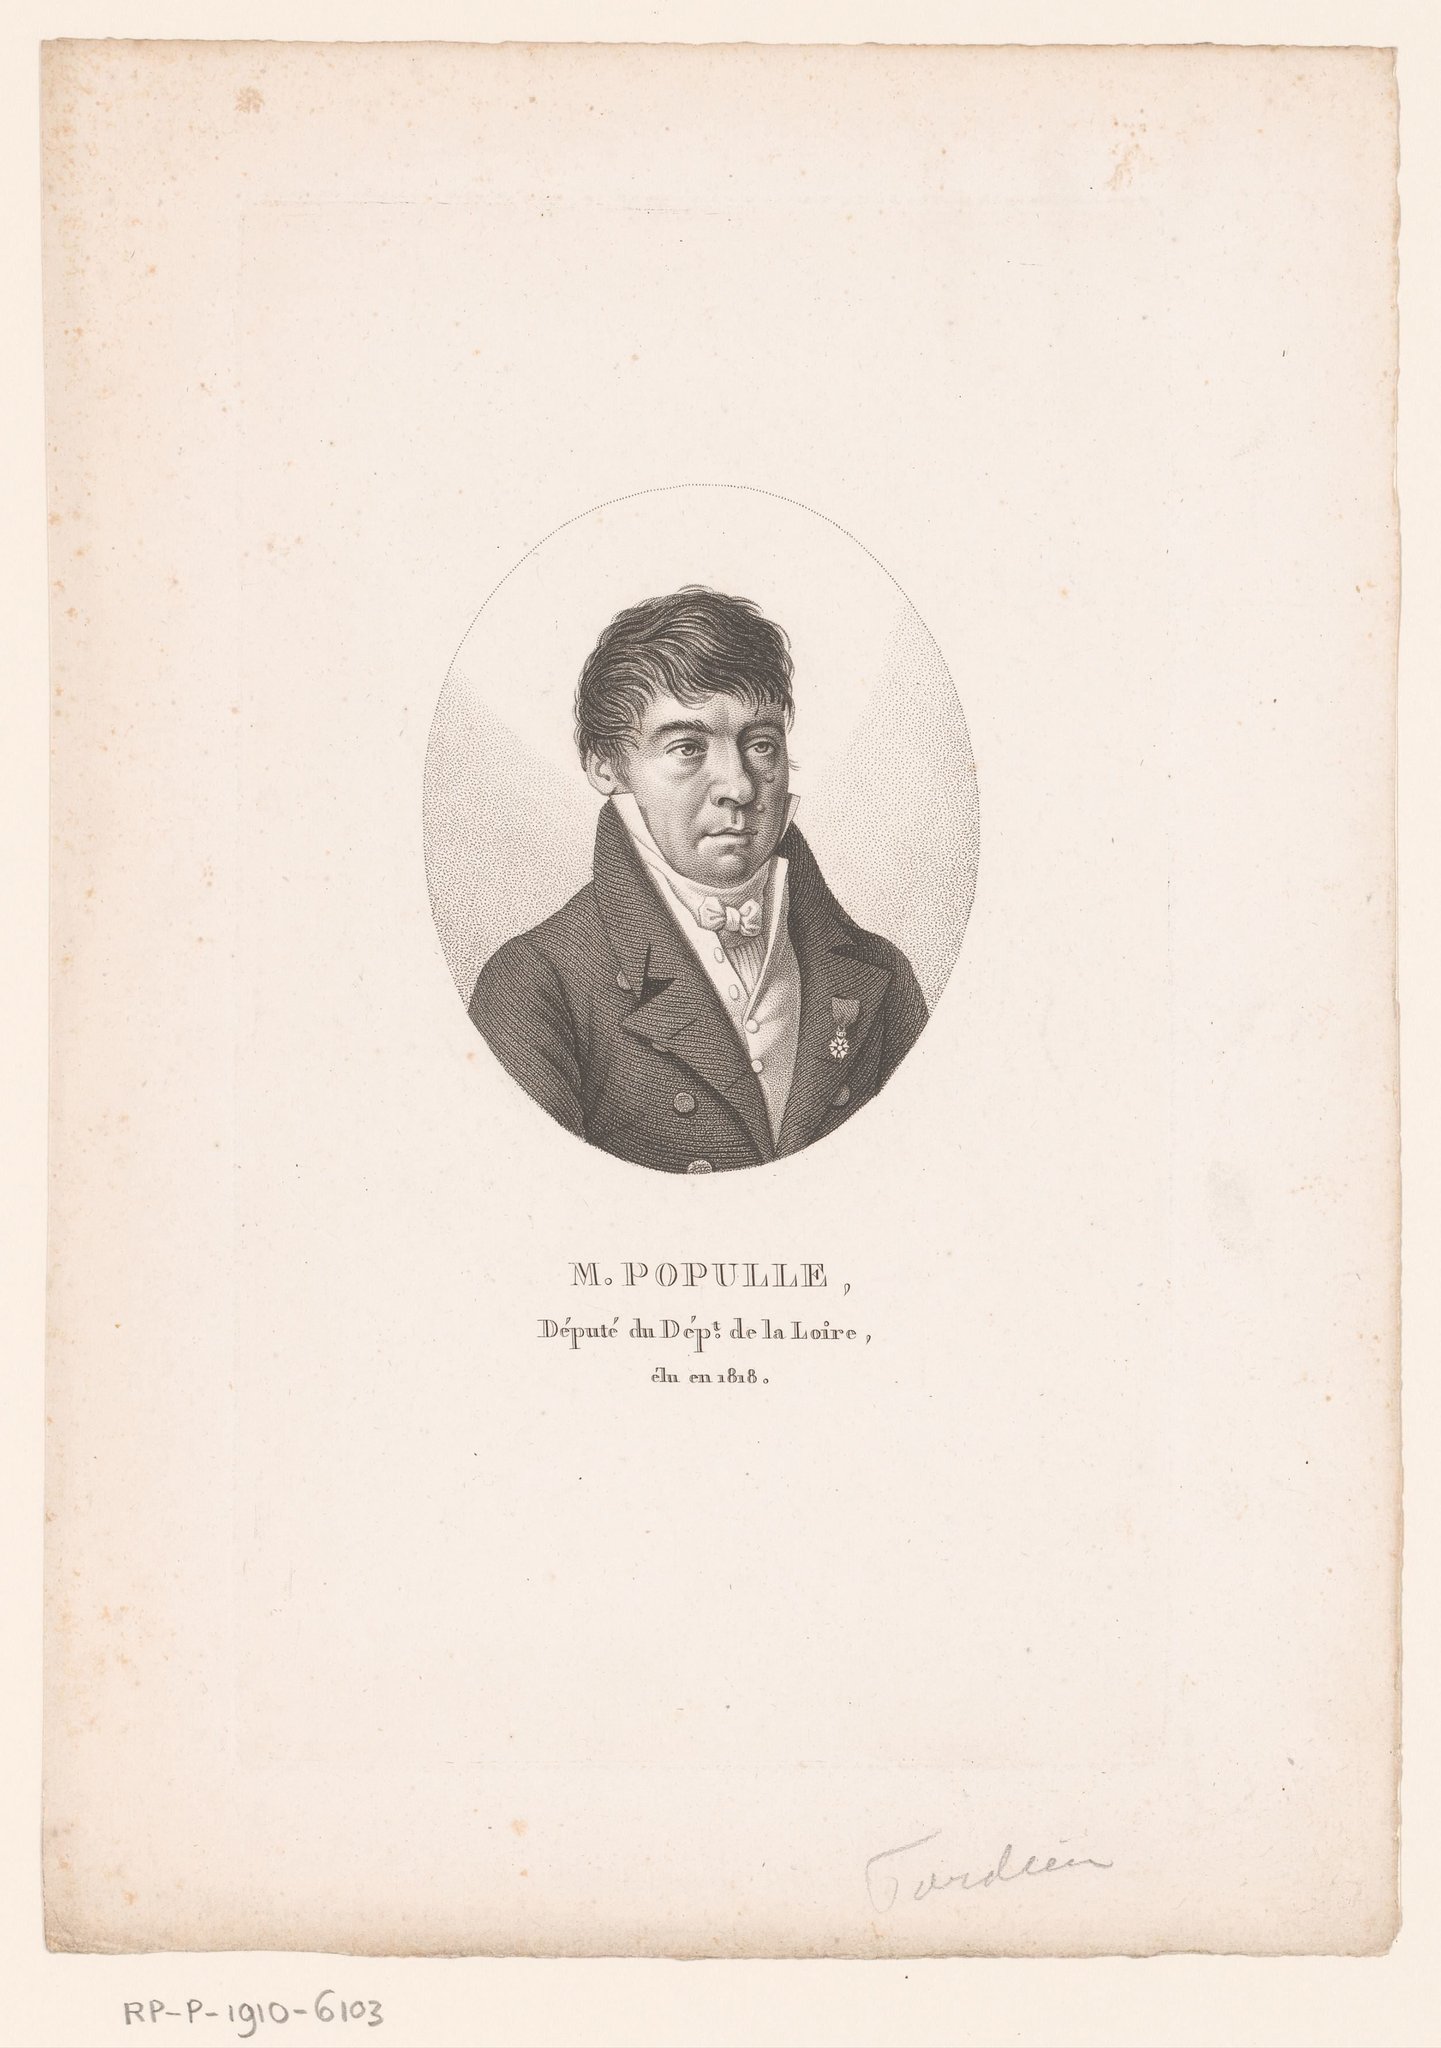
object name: print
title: Portret van François Populle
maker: ambroise tardieu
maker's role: print maker, printer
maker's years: 1788-1841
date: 1820-1821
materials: paper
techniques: engraving, roulette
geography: paris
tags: politician, historical persons, politician, e.g. party leader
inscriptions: collector's mark: Lugt 2228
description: Prent uit: Tardieu, Ambroise. Portraits des députés, écrivains et pairs constitutionnels, défenseurs invariables de la charte et de la loi des élections du 5 février 1817. Parijs: Tardieu, Ambroise, 1820-1821.